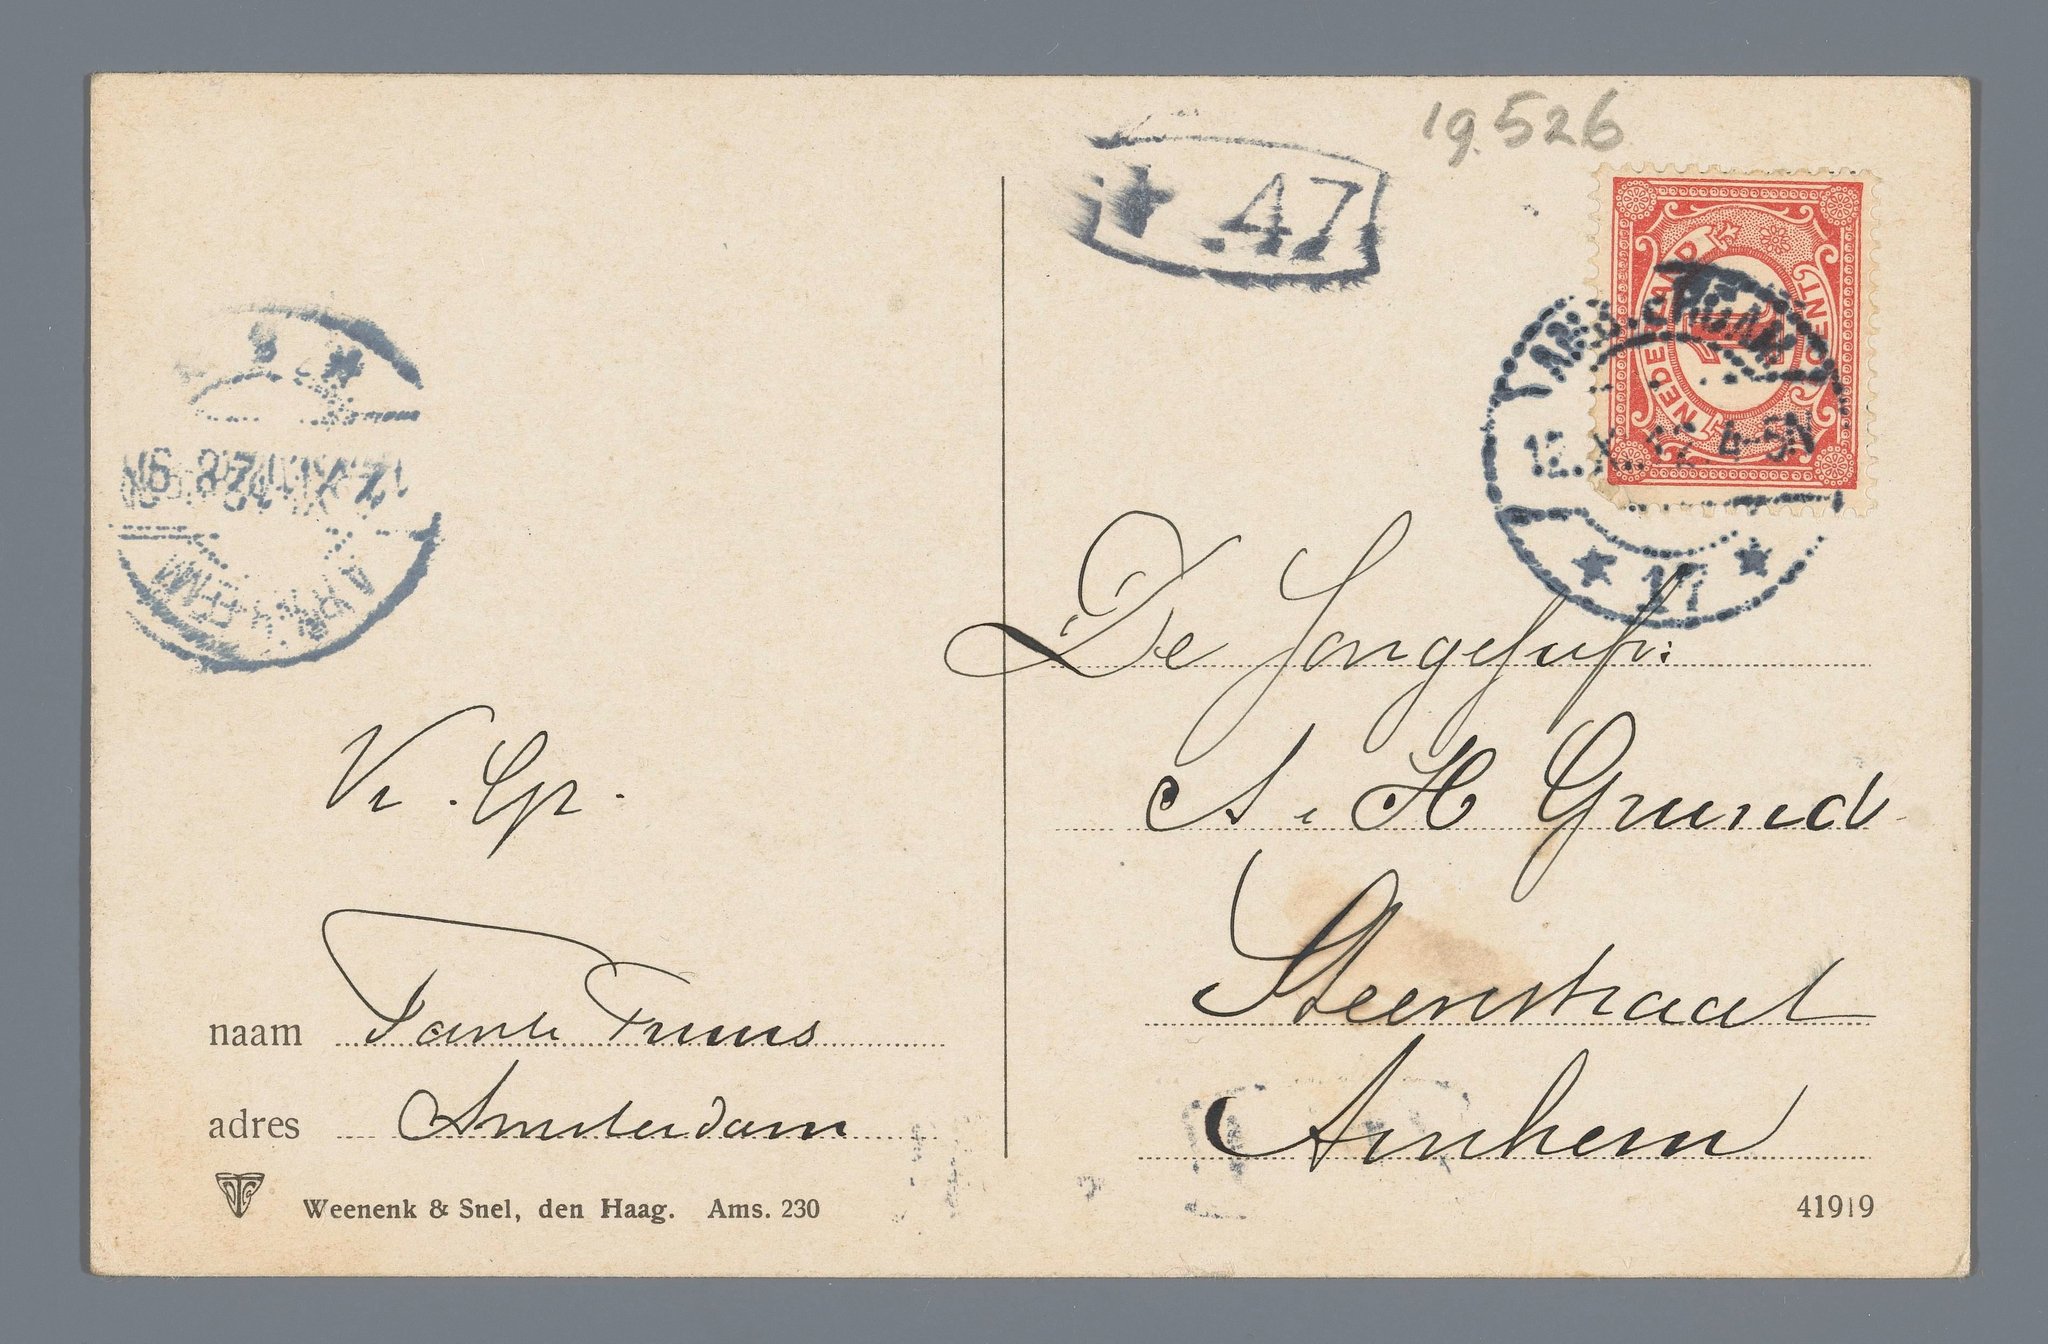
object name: stereograph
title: Gezicht op vijvers in de tuin van Versailles, met op de voorgrond de Apollovijver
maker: Anonymous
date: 1850-1875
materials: cardboard, photographic support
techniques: albumen print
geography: gardens of versailles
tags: (story of) apollo (phoebus), garden fountain, sculpture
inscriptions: inscription: ‘Panorama des Grandes Eaux Versailles’